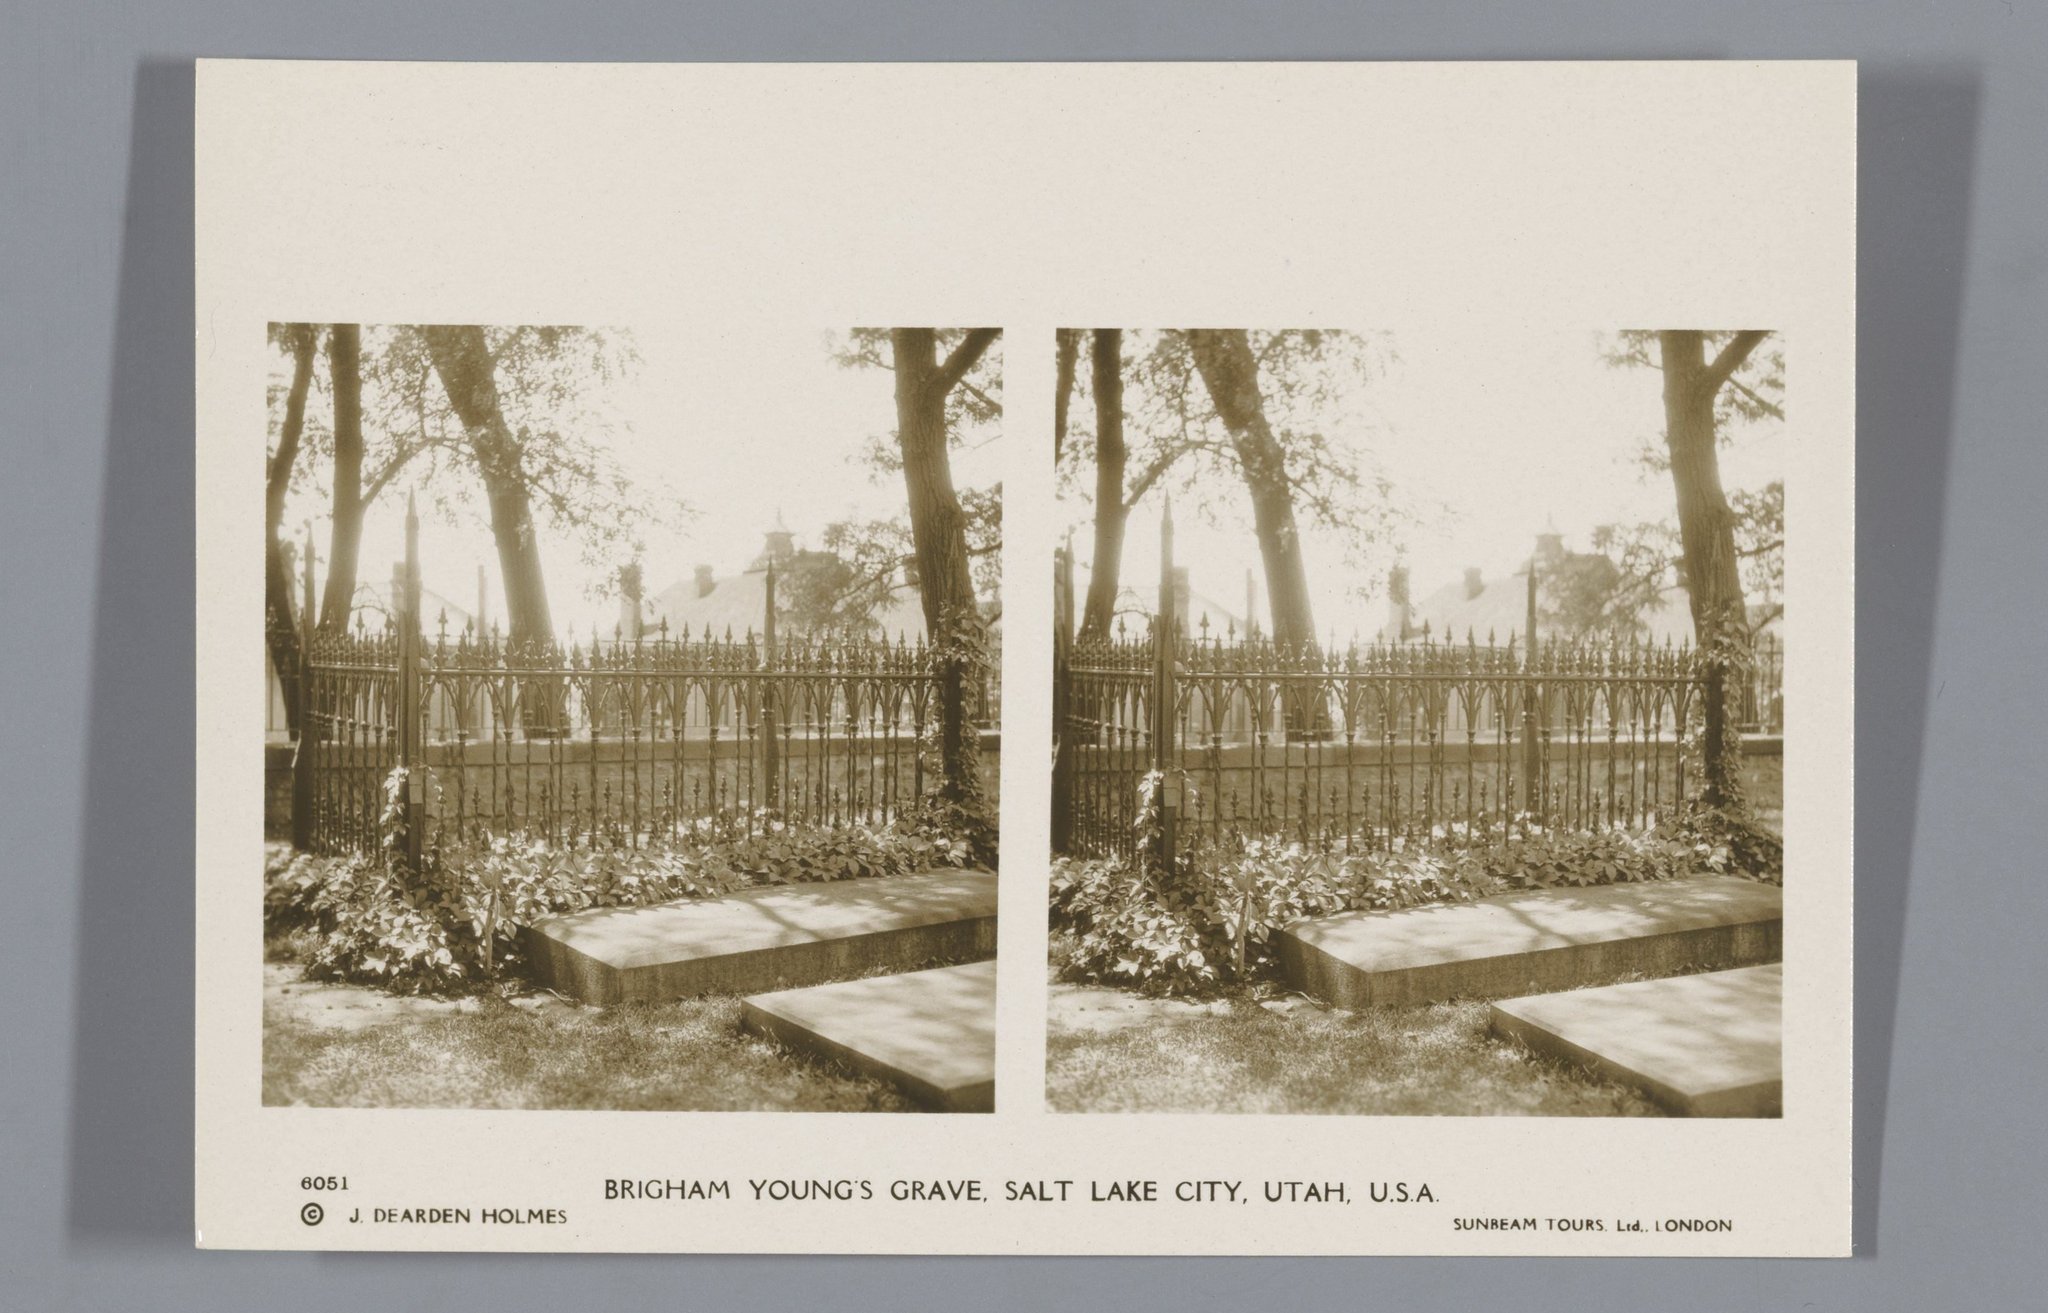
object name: stereograph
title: 6 "Picturescope" Views of Salt Lake City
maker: james dearden holmes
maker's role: fotograaf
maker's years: 1873-1937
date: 1924-1926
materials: paper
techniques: gelatin silver print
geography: birmingham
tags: movements derived from protestant churches (with name), grave, tomb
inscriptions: number: ‘6051’